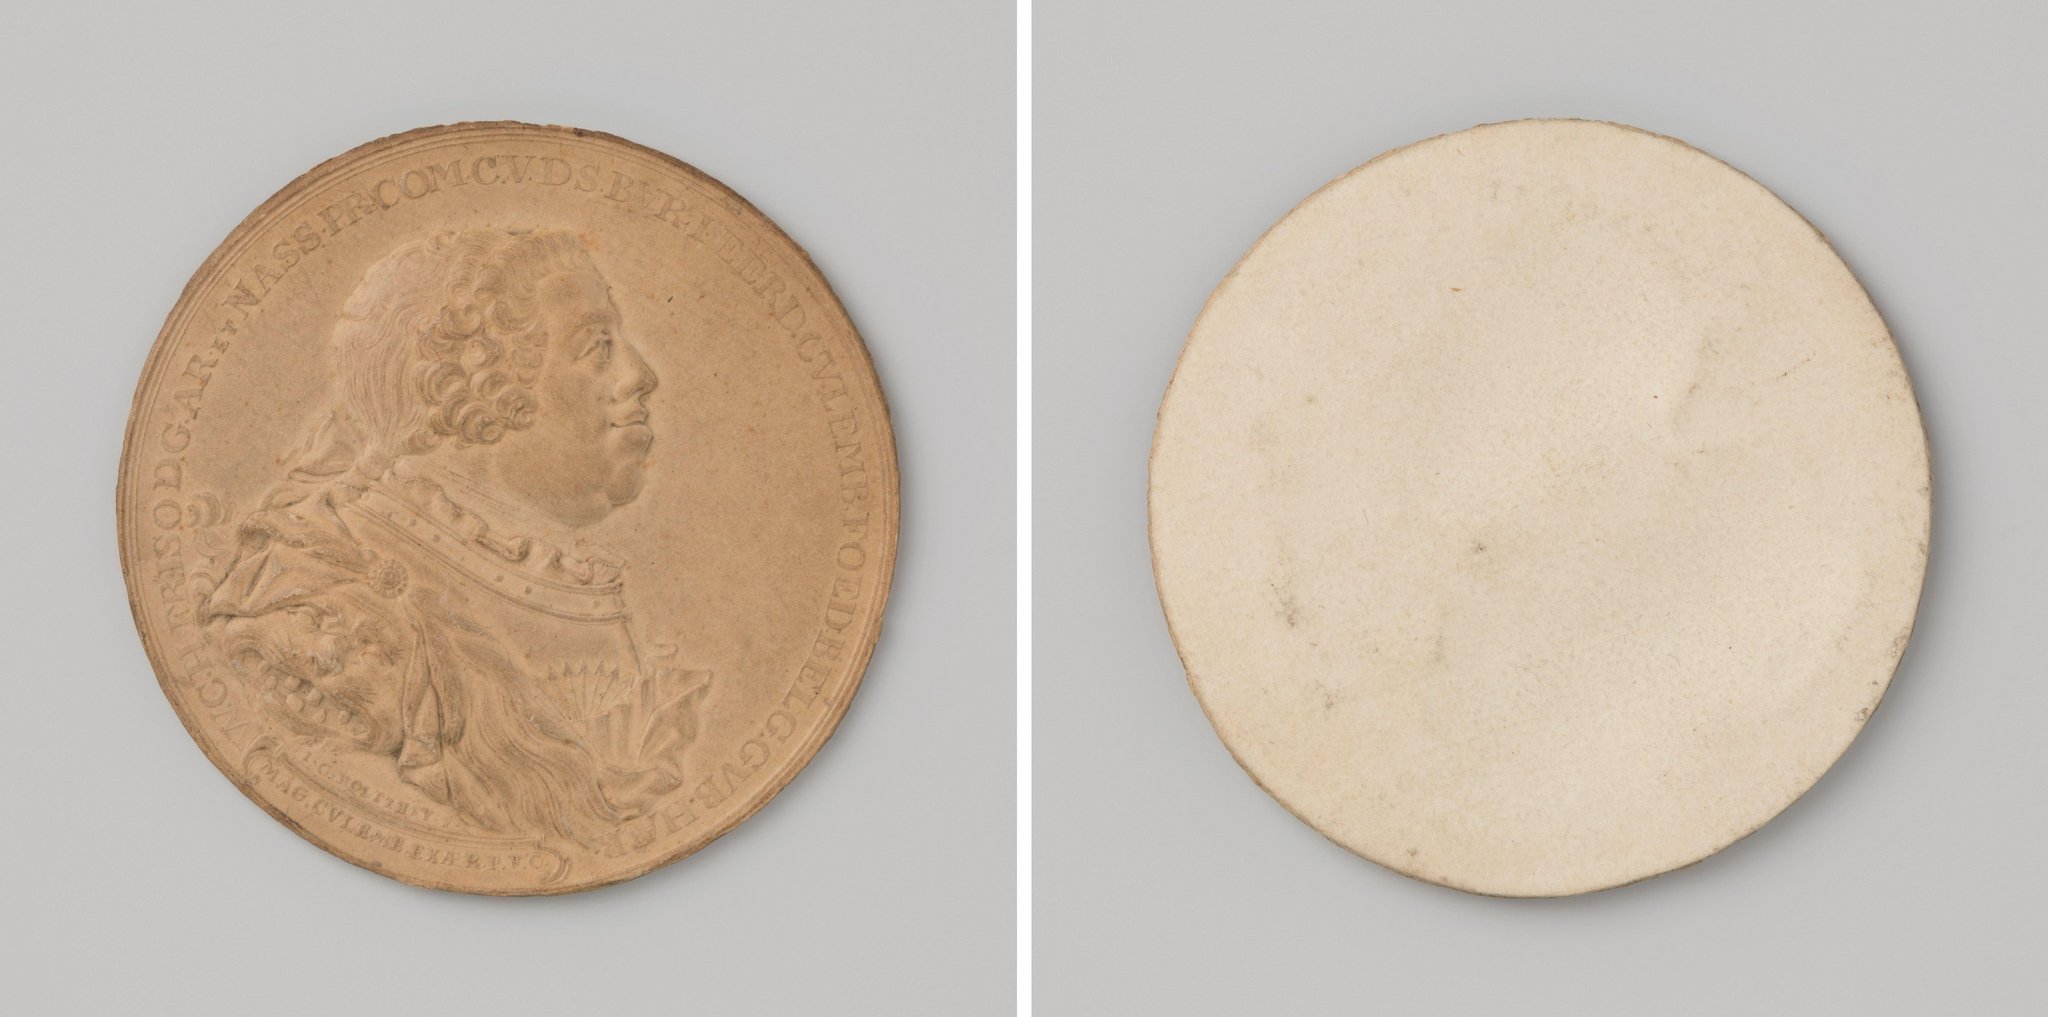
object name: history medal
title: Overdracht van het graafschap Culemborg aan Stadhouder Willem IV 1748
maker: johan george holtzhey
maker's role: mintmaster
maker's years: 1726-1808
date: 1748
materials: cardboard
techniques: pressing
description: Afslag in karton van het voorzijdstempel, waarop het borstbeeld van Stadhouder Willem IV naar rechts met omschrift en afsnedetekst.